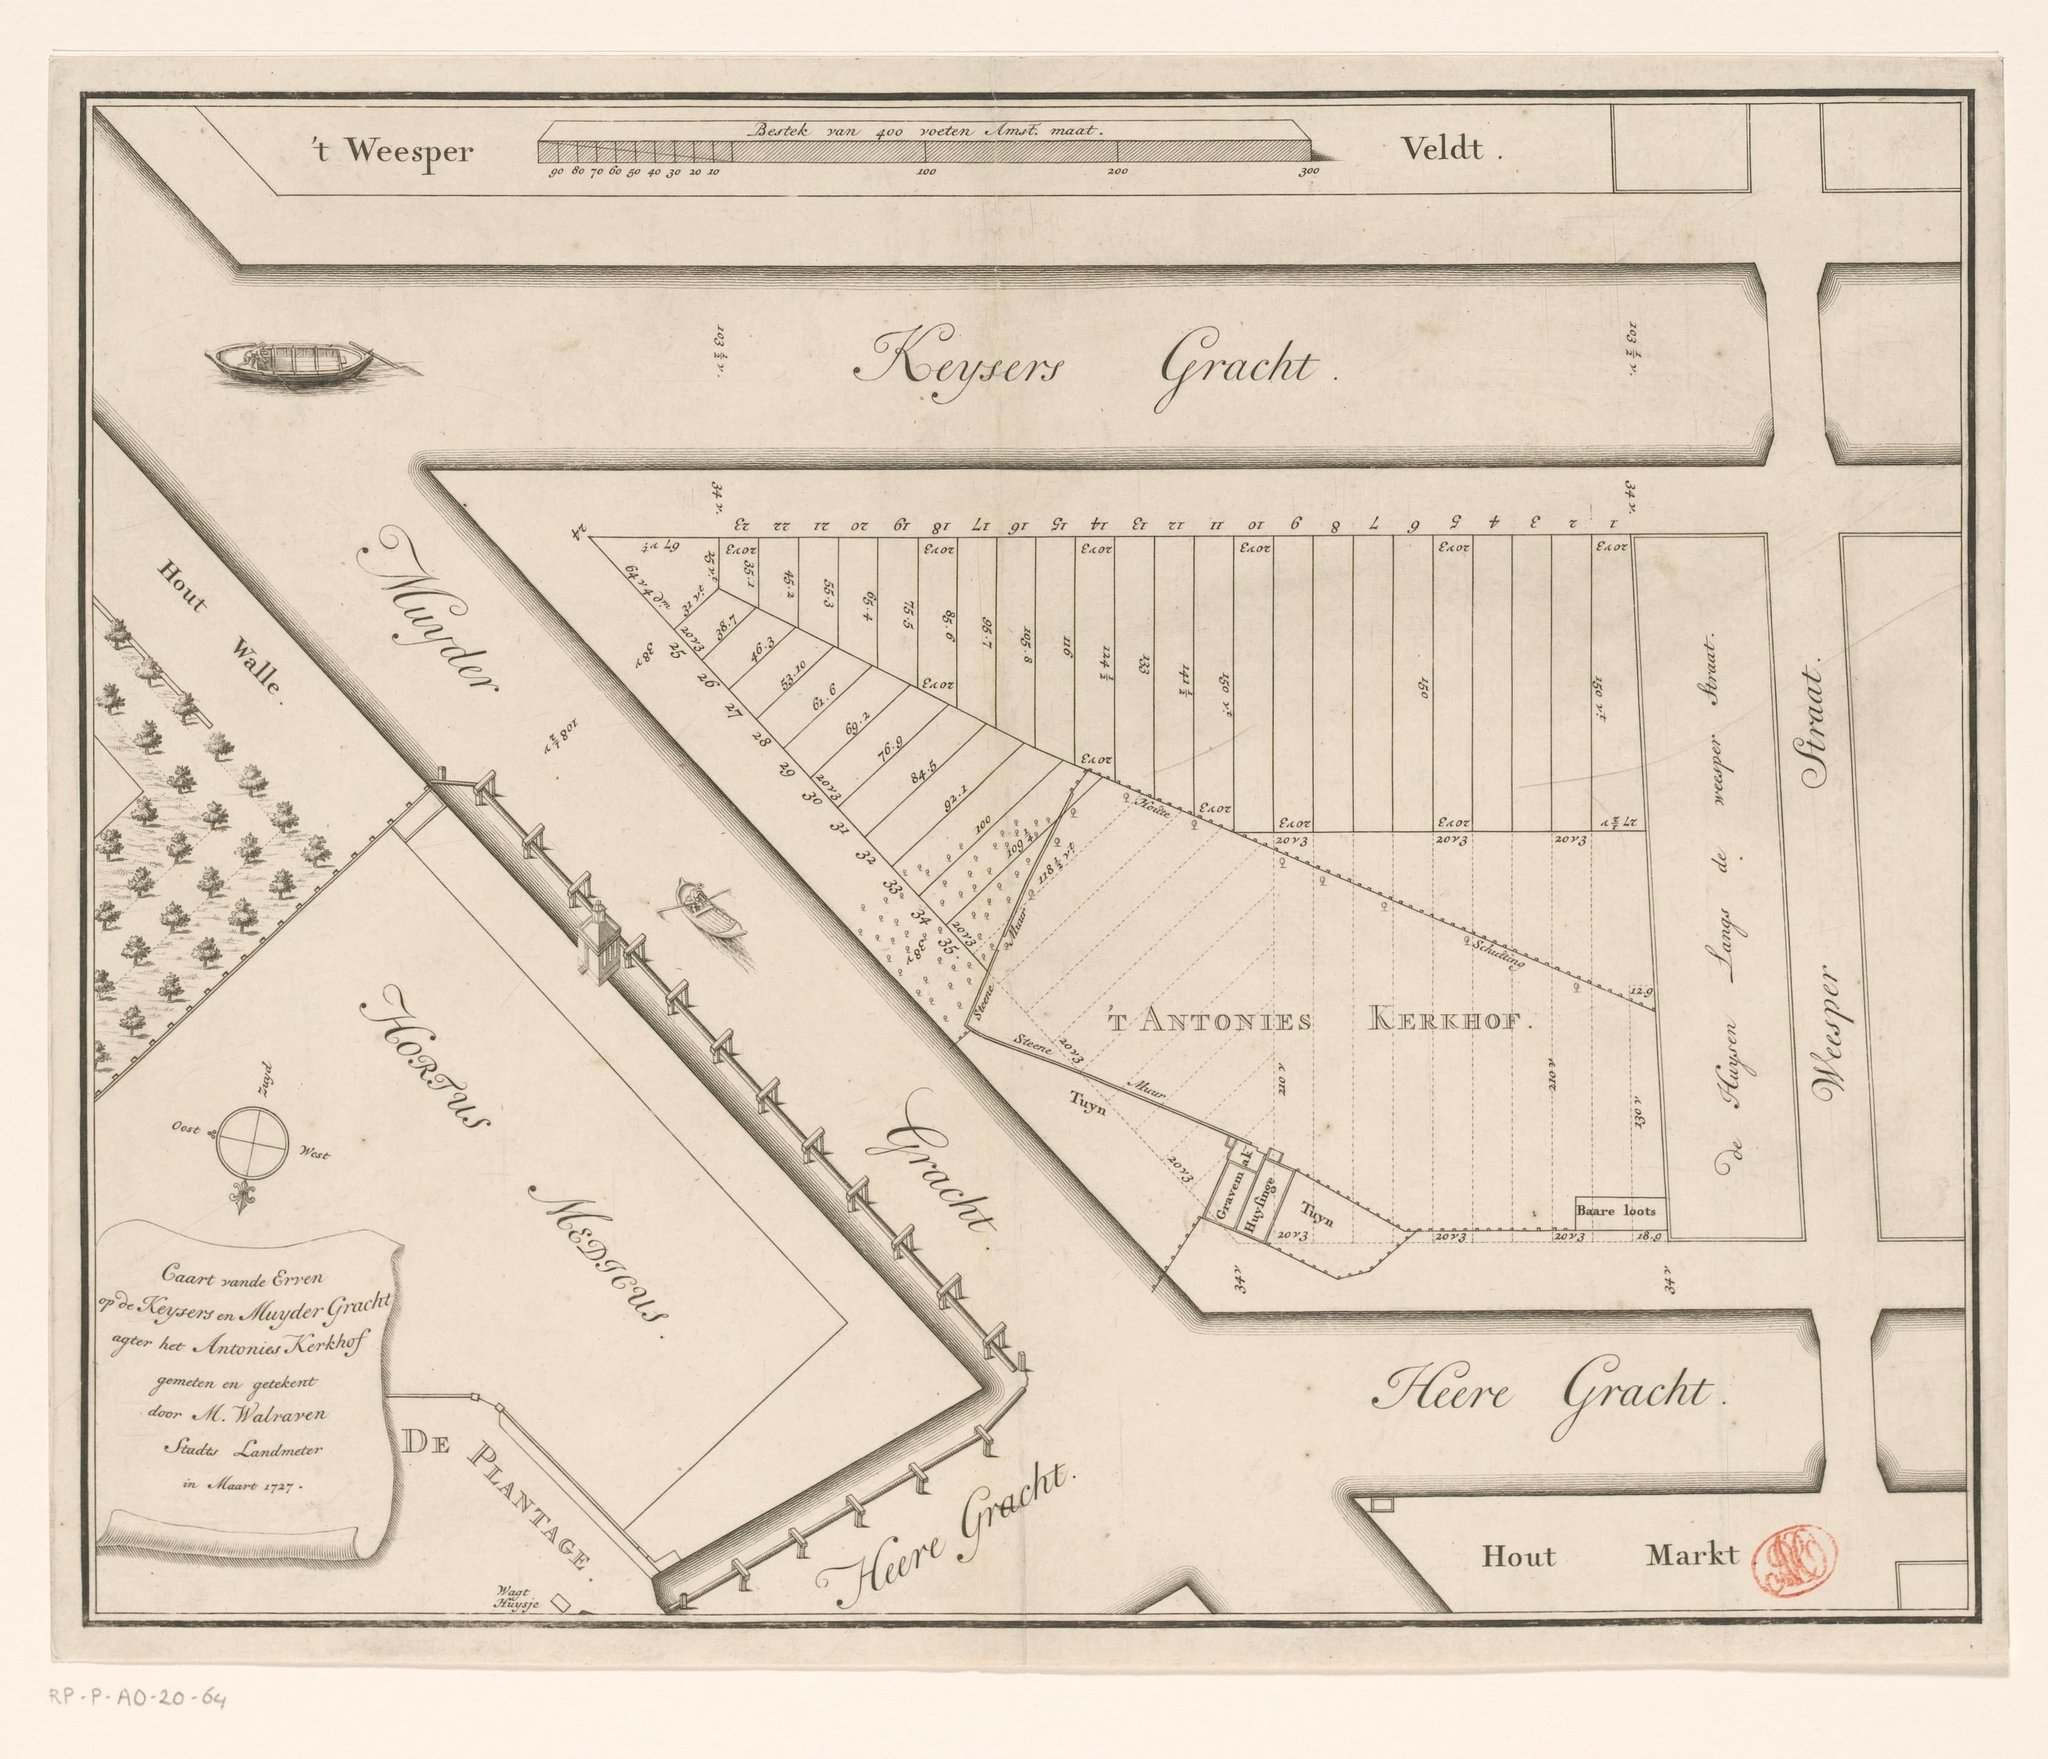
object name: area plan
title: Plattegrond met de erven aan de Plantage Muidergracht en Nieuwe Keizersgracht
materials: paper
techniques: engraving, etching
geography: amsterdam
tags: maps of cities, amsterdam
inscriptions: collector's mark: Lugt 195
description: Plattegrond met de erven aan de Plantage Muidergracht en Nieuwe Keizersgracht, gelegen achter het Sint-Anthonis Kerkhof en tegenover de Hortus. Boven een schaalstok: Bestek van 400 voeten Amst. maat. Linksonder de titelcartouche.